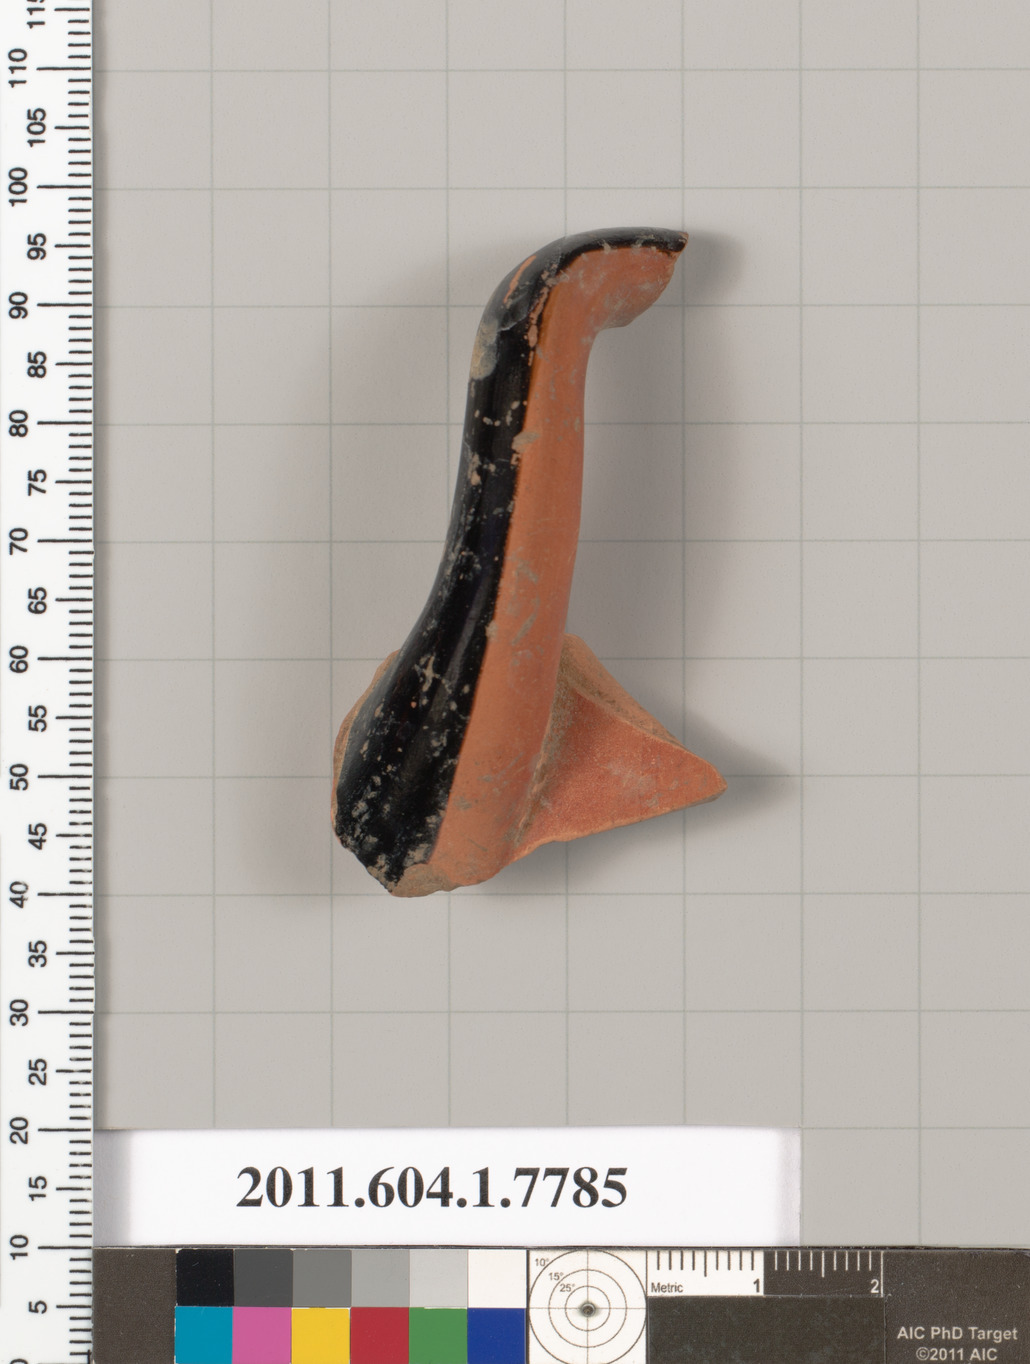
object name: kylix fragment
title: Terracotta fragment of a kylix (drinking cup)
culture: greek, attic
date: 460-450 BCE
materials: terracotta